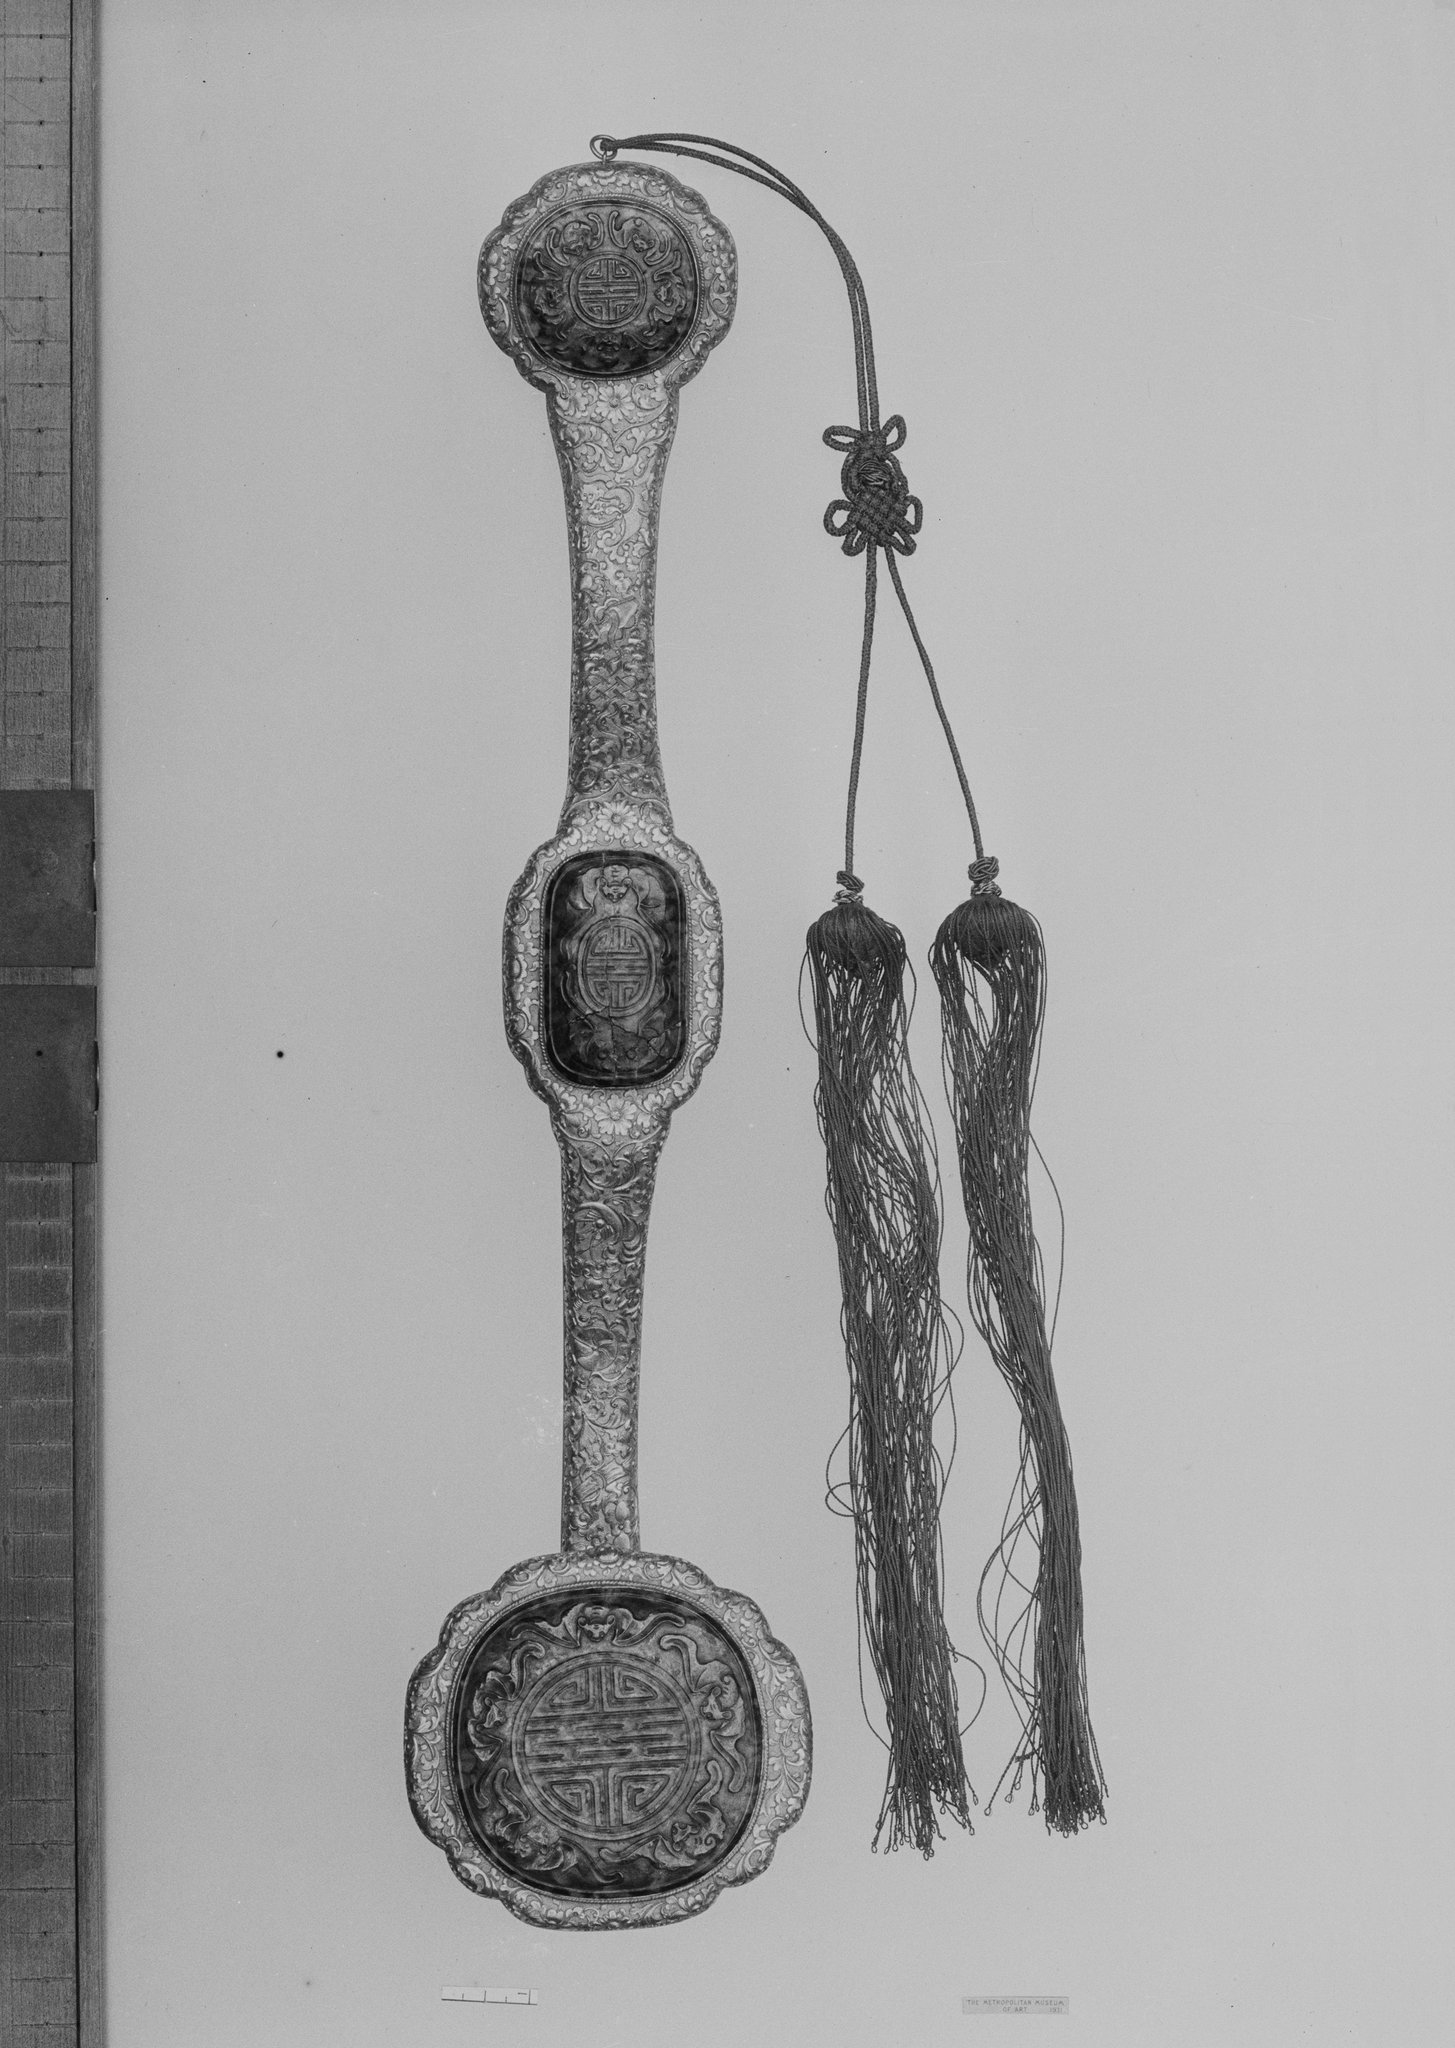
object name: sceptre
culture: chinese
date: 1736-1795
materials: jade